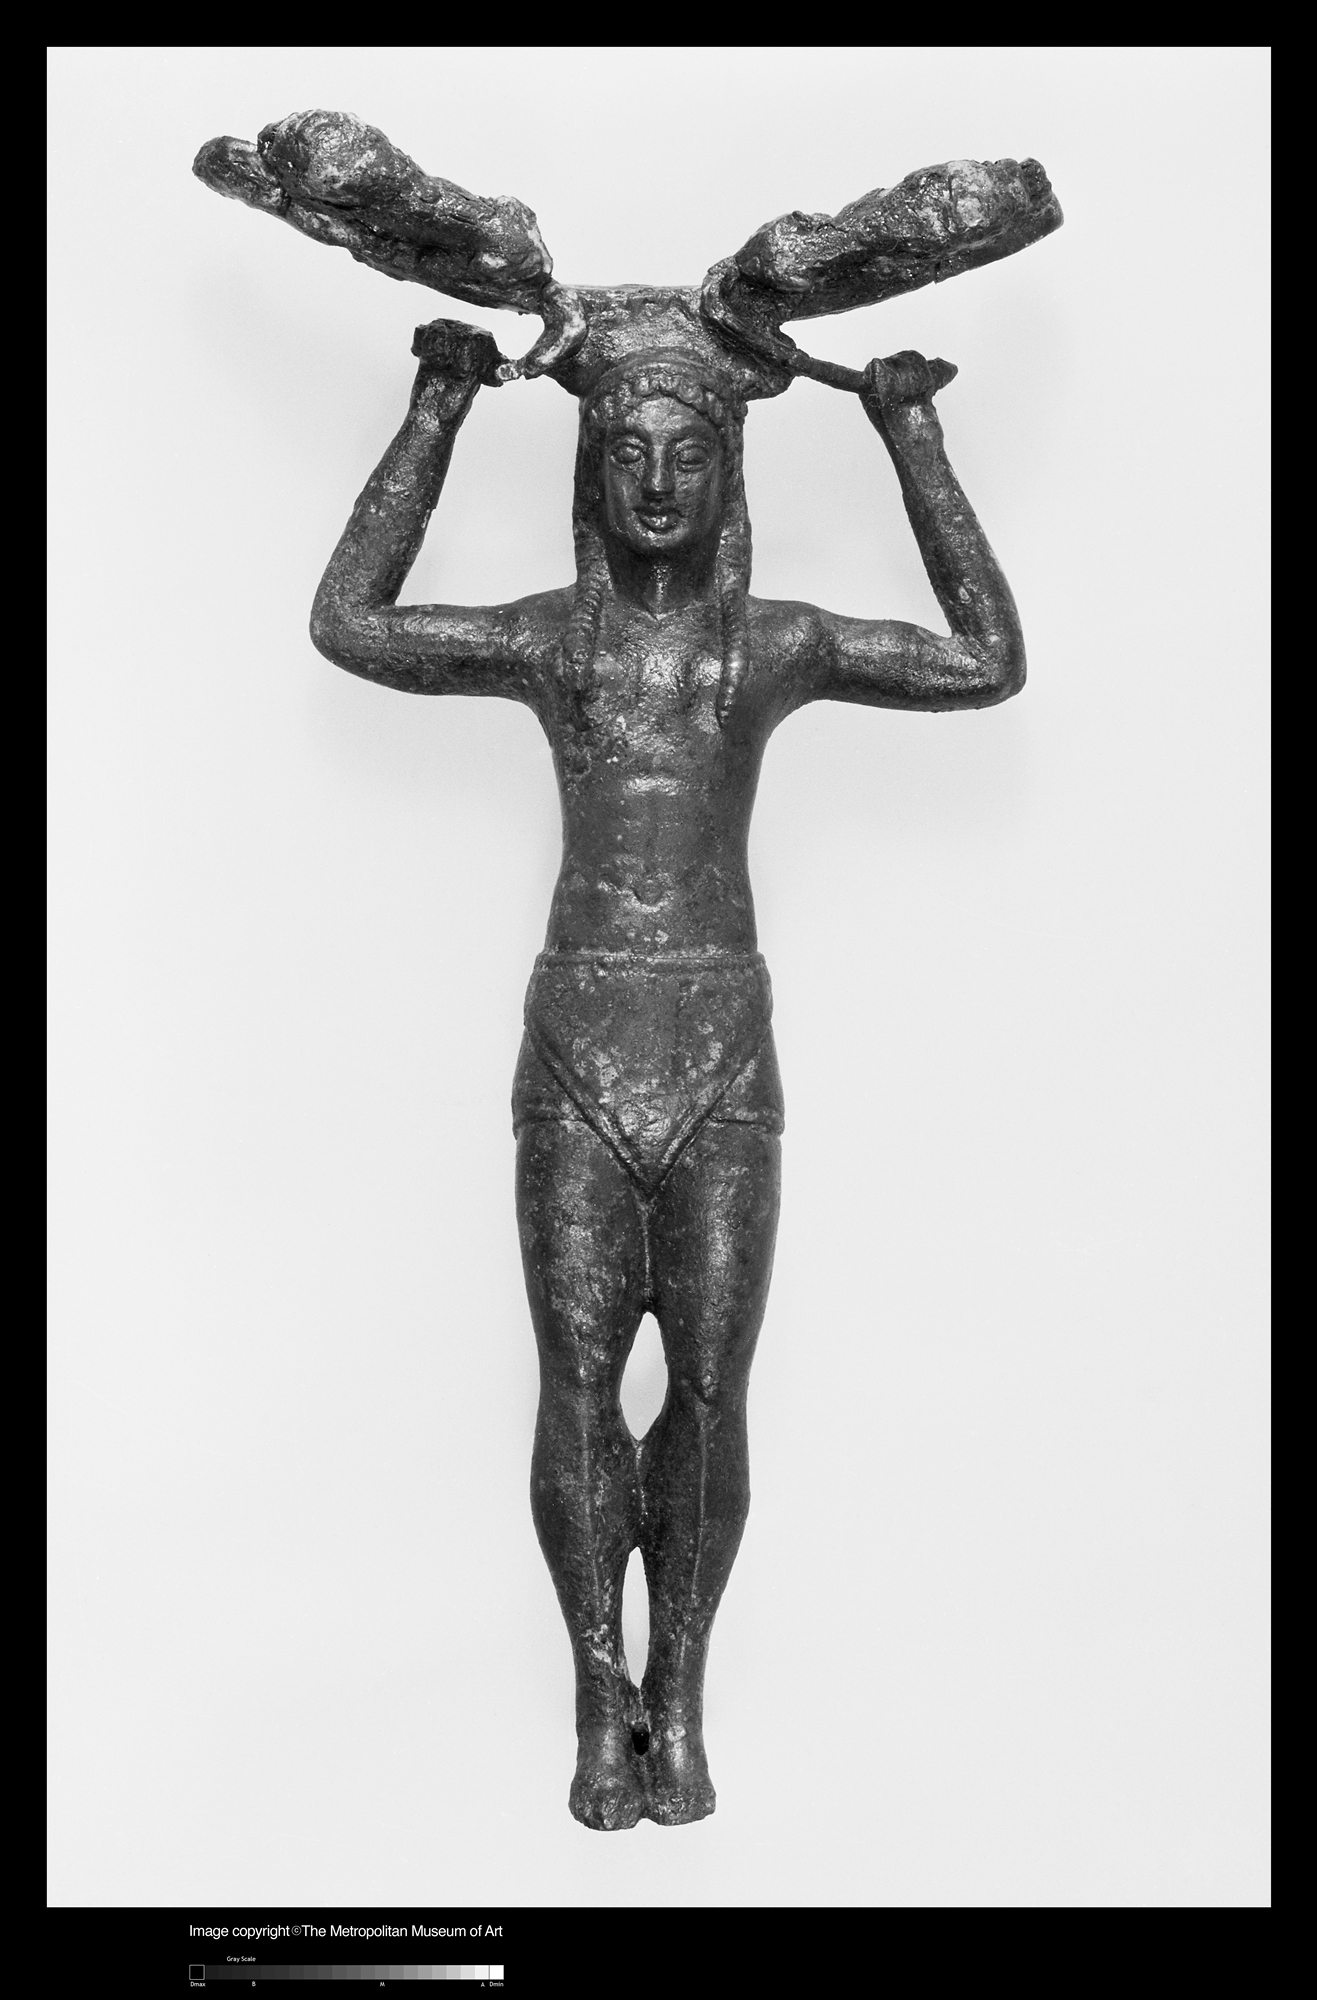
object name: handle of a patera in the form of a girl acrobat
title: Bronze patera handle in the form of a young woman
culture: greek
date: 525-501 BCE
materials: bronze